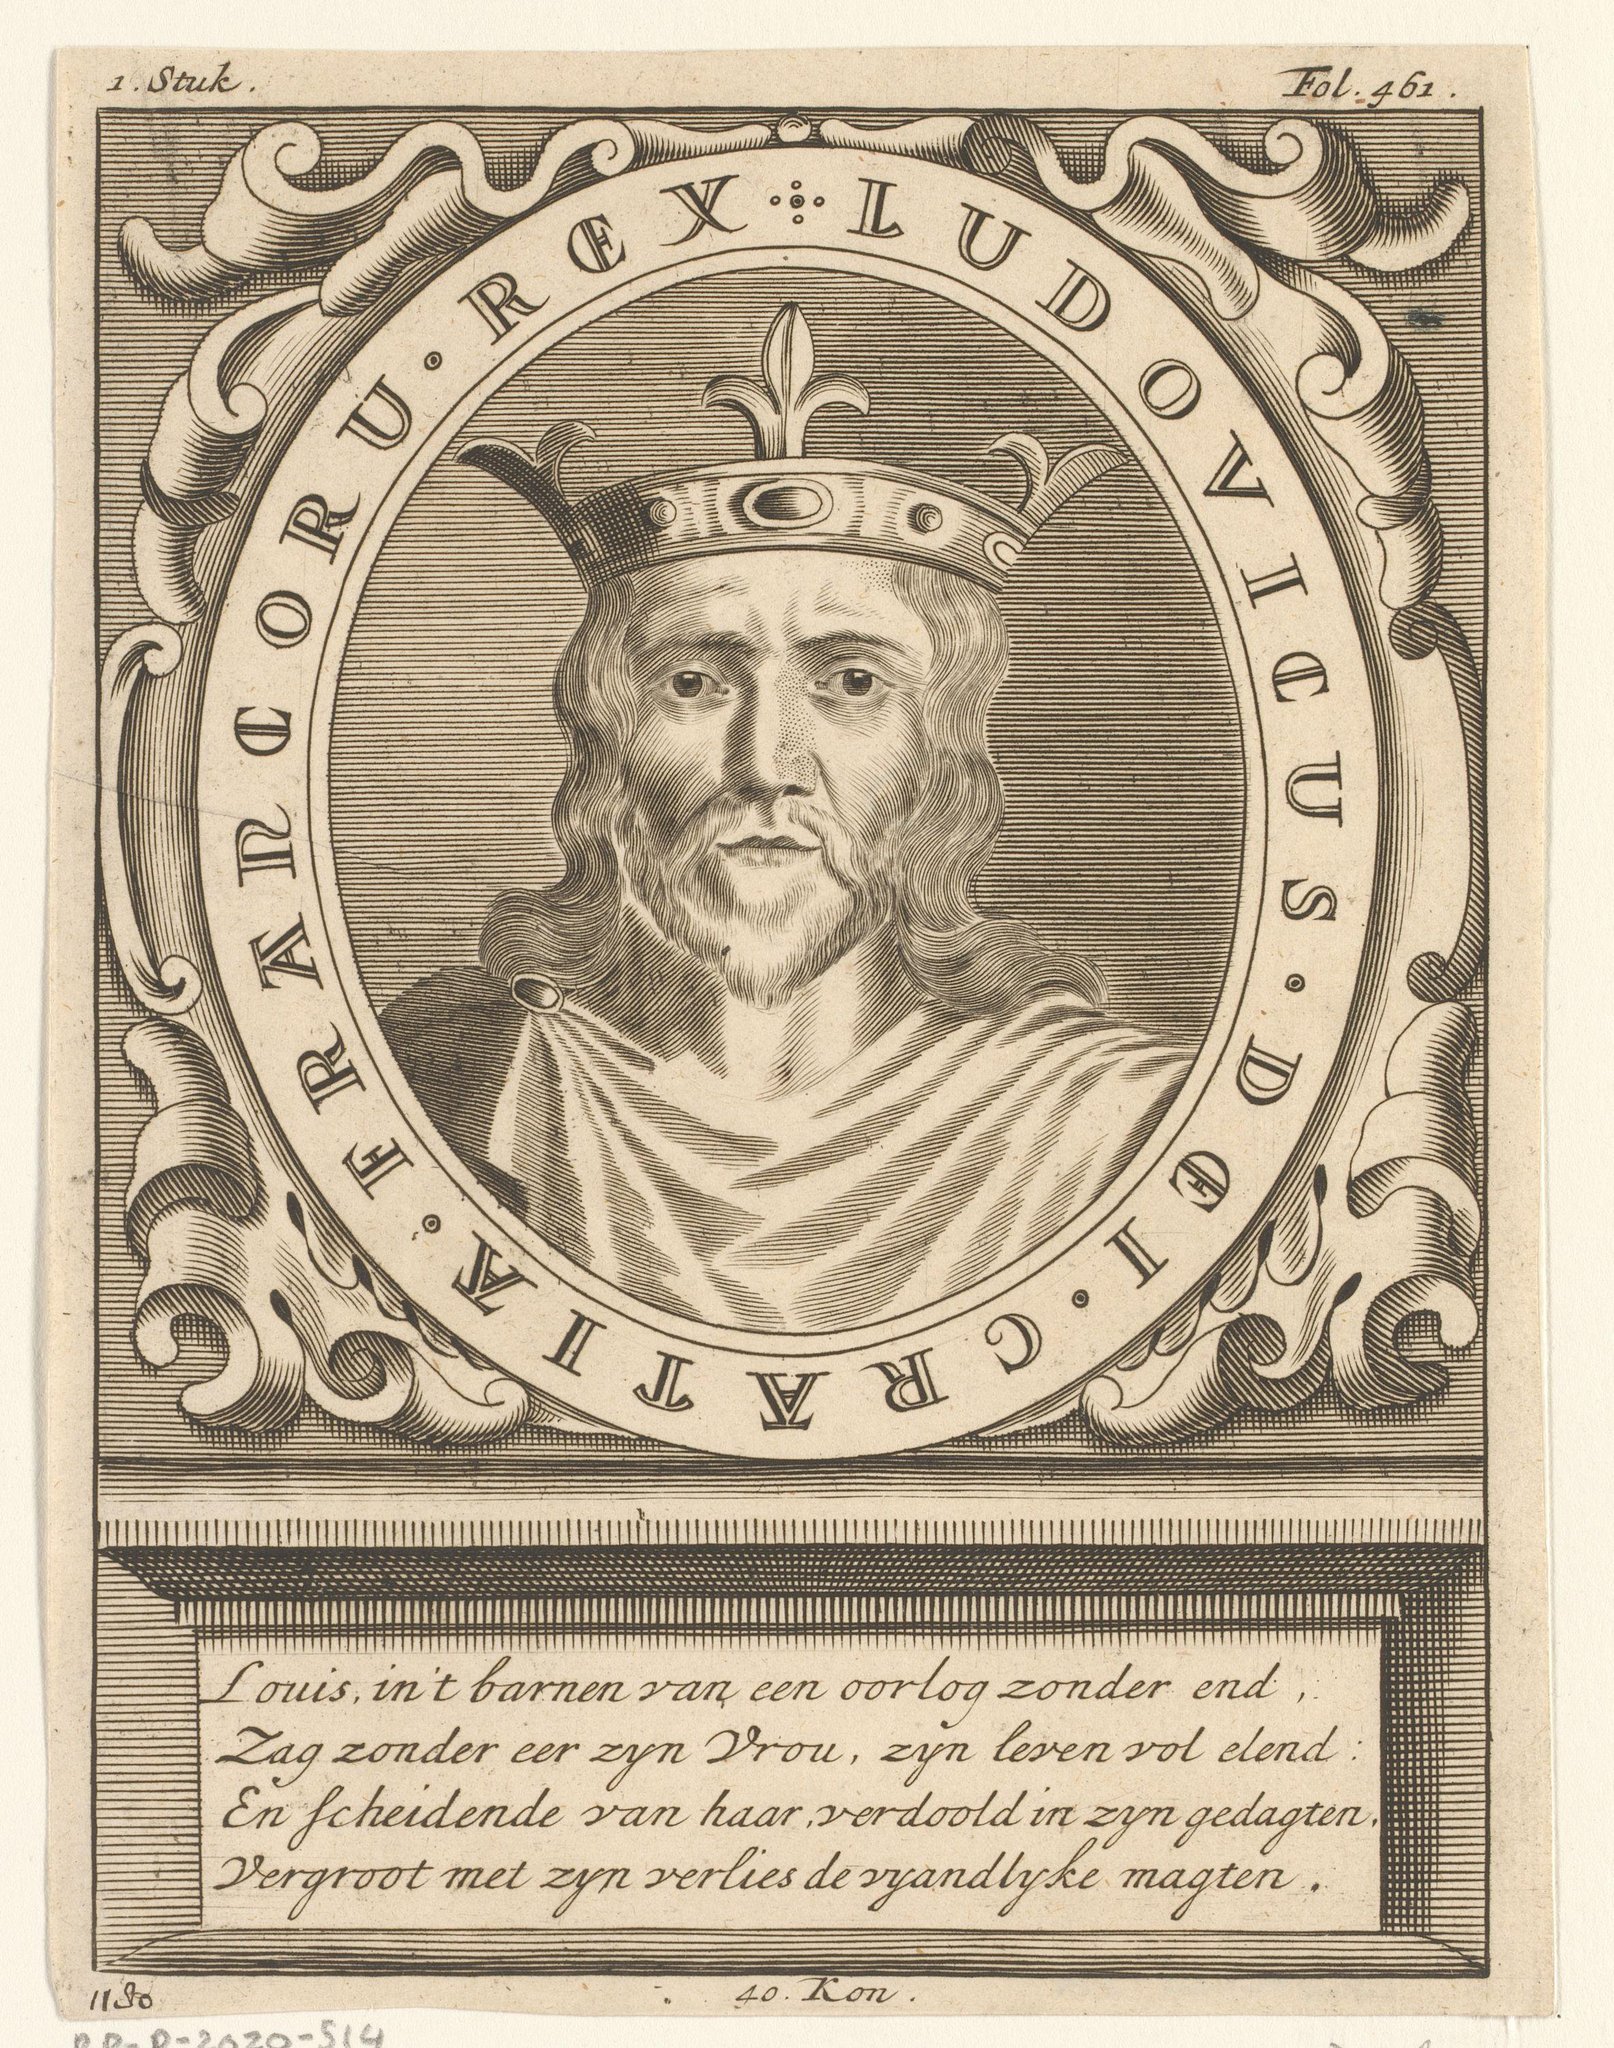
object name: print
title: Portret van Lodewijk VII, koning van Frankrijk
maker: Anonymous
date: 1685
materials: paper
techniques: engraving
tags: paris, historical persons, king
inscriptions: collector's mark: Lugt 2228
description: Prent gebruikt in: Eudes de Mézeray, François. Chronyk van Vrankryk. 6 dln. Amsterdam: Jan Bouman en Timotheum ten Hoorn, 1685, dl. 2.